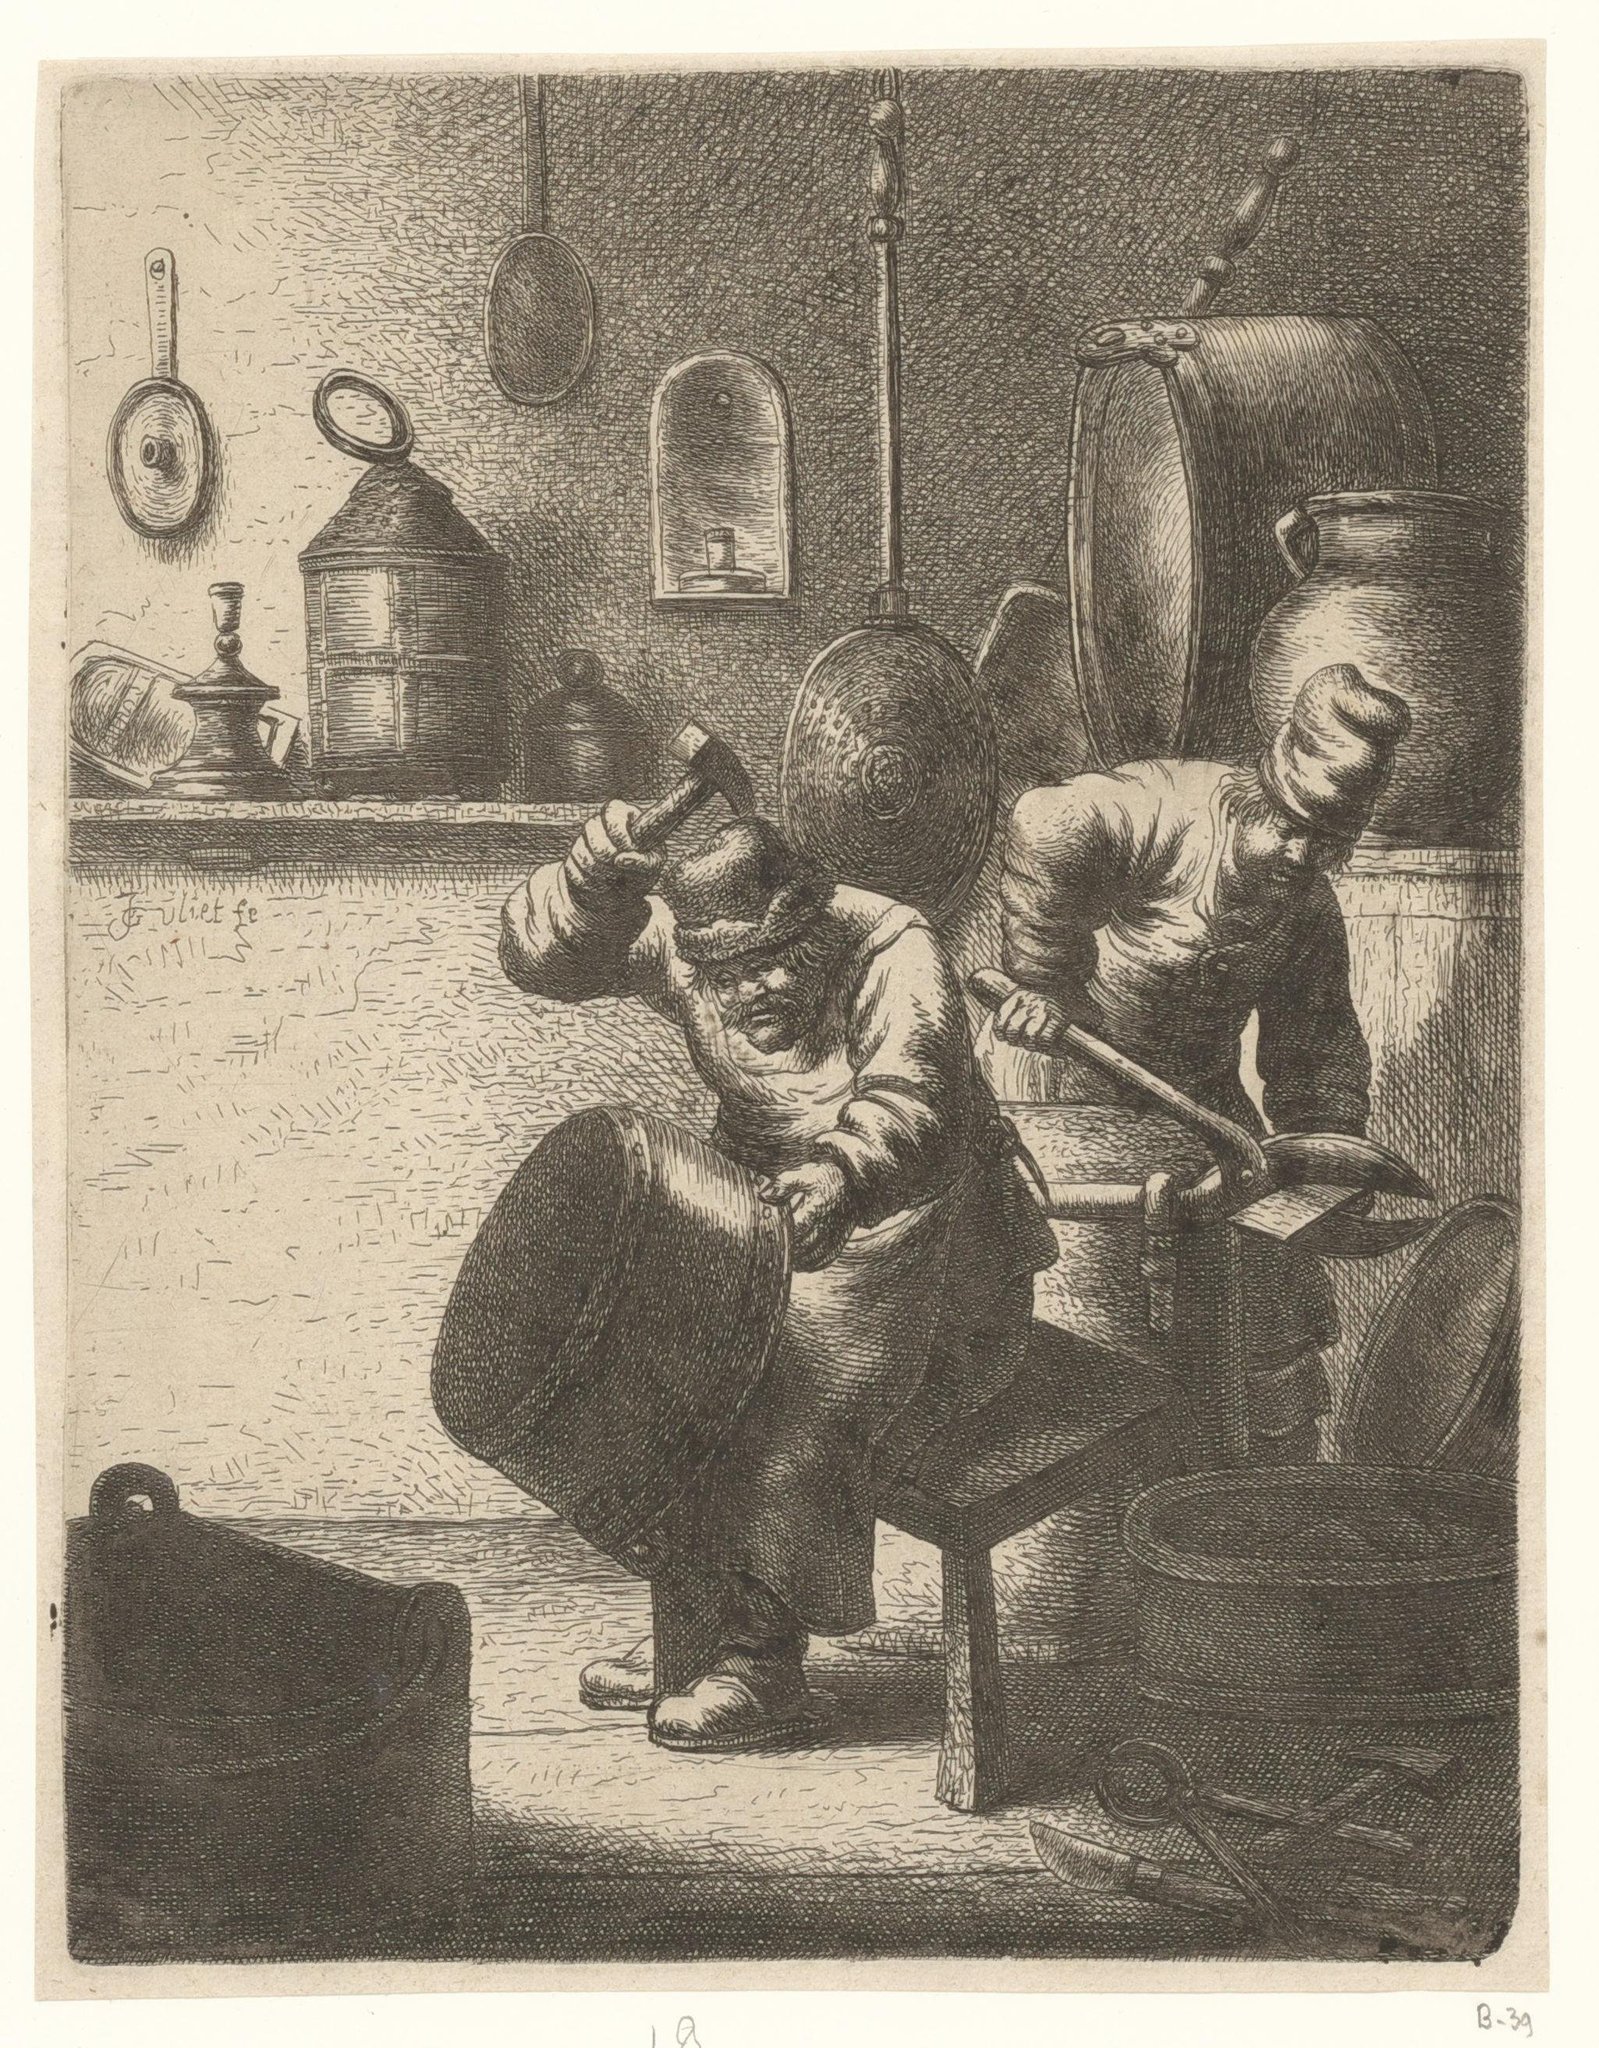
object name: print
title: Beroepen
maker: jan gillisz. van vliet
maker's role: draughtsman, painter, print maker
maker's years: 1600-1668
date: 1635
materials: paper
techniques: etching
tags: coppersmith, brassworker, industries ~ metal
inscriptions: collector's mark: Lugt 1641, stamp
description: Twee koperslagers in een werkplaats; een van hen hamert op een kuip, de ander snijdt een koperplaat. Onderwerpsrubrieken binnen de Atlas Zeden en Gewoonten: Handel, Nijverheid en Verkeer, Beroep en bedrijf, Complete suites.